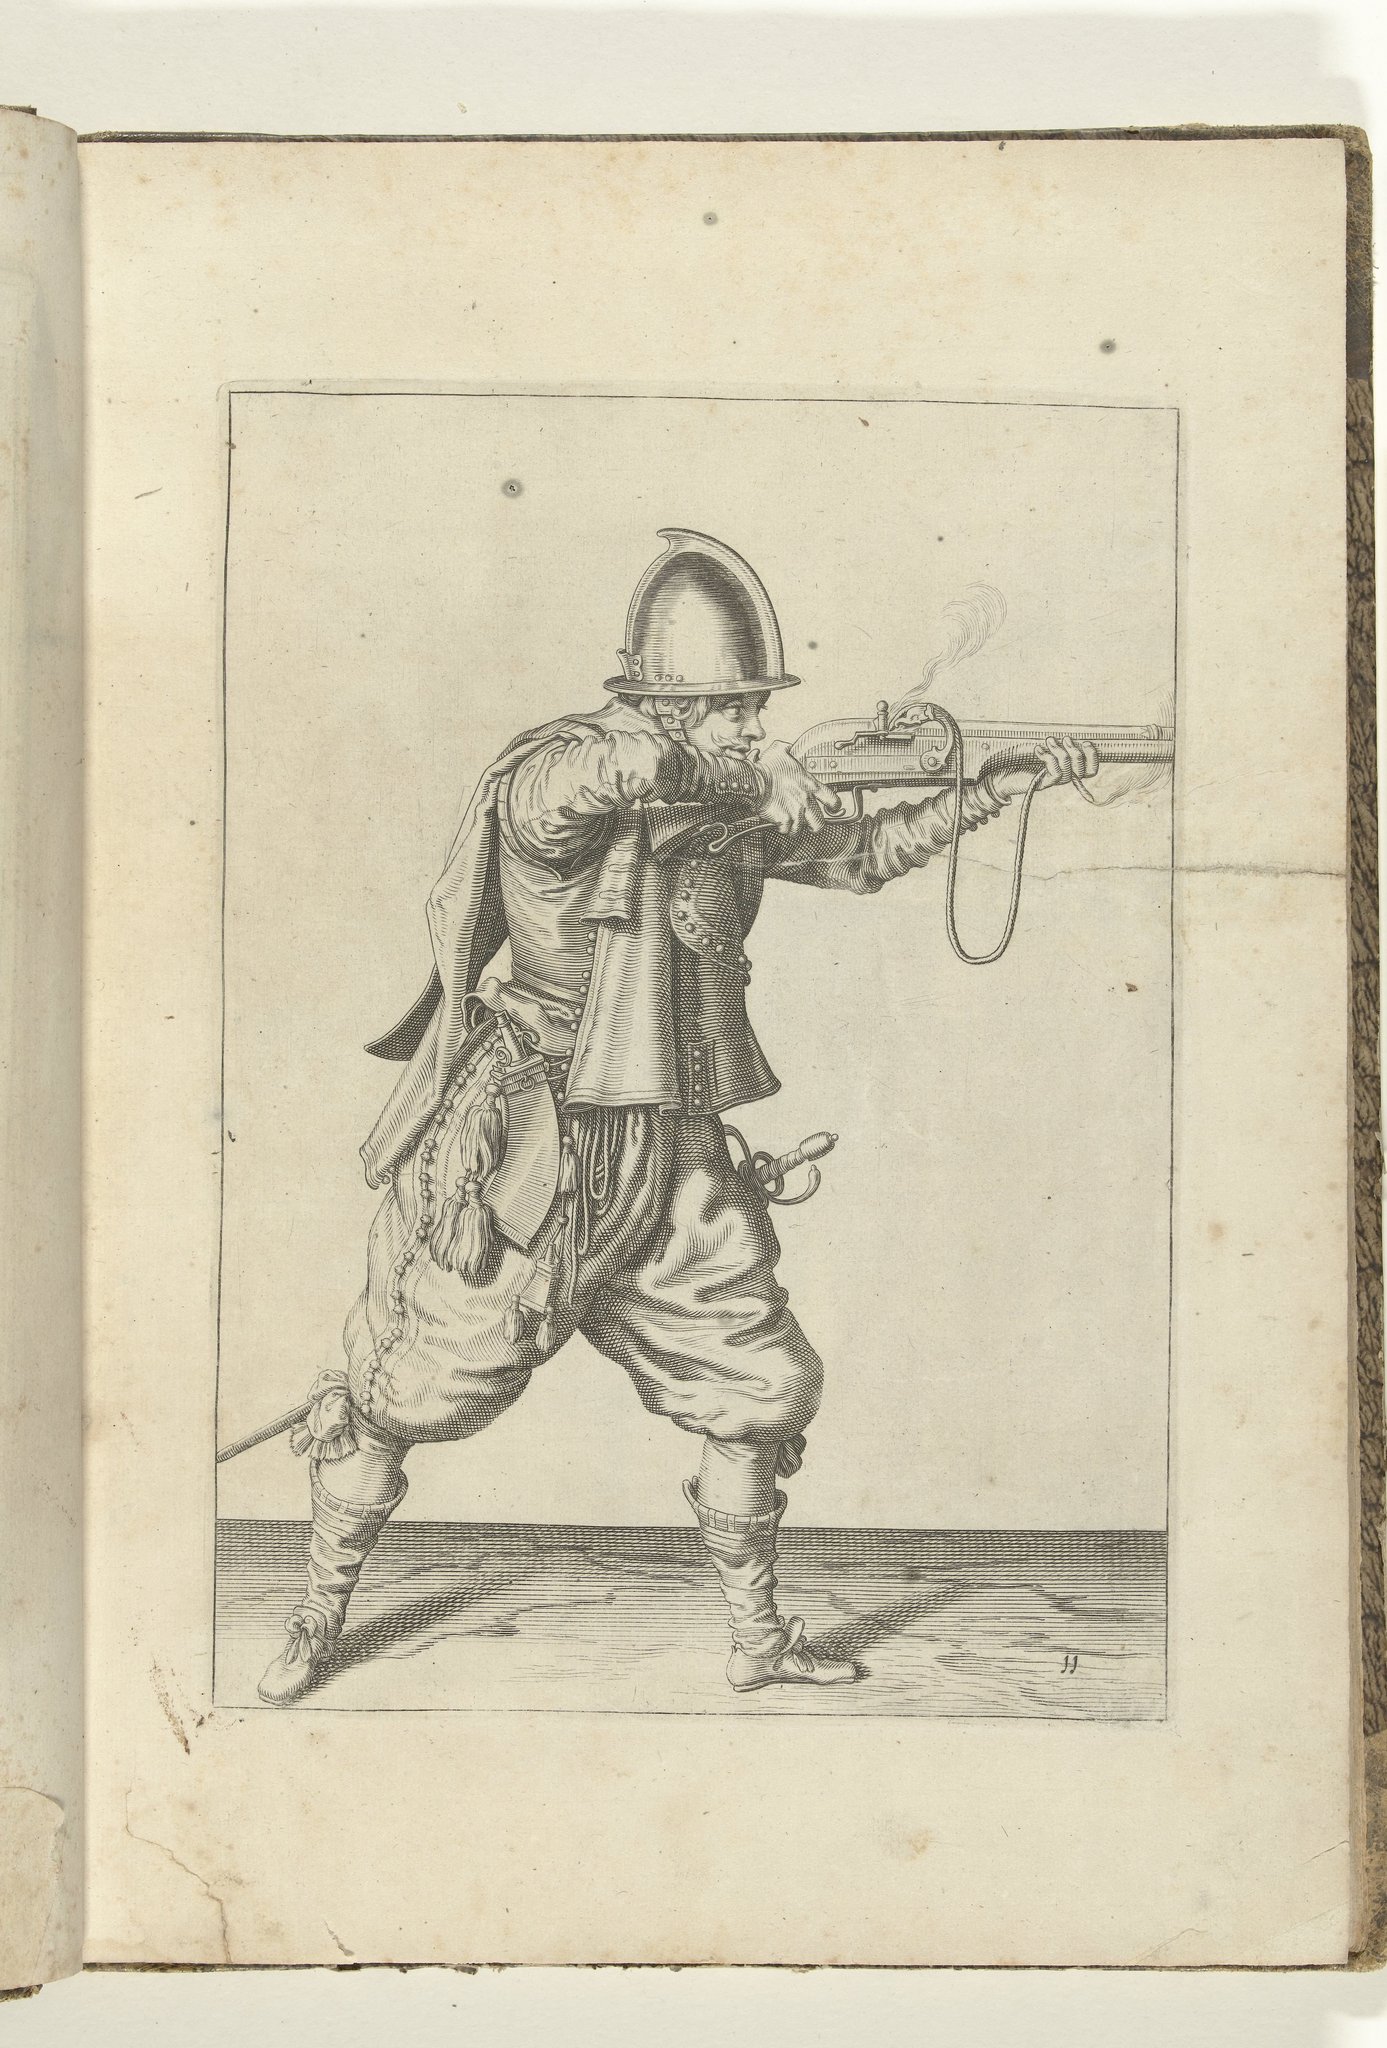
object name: print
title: Soldaat richt en vuurt de roer (nr. 11), ca. 1600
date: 1597-1608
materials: paper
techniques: engraving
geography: northern netherlands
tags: maurice (prince of orange), handling of weapons ~ military training, weapons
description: Een soldaat, ten voeten uit, naar rechts, die een roer (een bepaald type vuurwapen) met beide handen horizontaal houdt, richt en vuurt (nr. 11), ca. 1600. Plaat 11 in de instructies voor het hanteren van de roer: Brief enseignement, sur la representation des figures, du droit maniement de l'Harquebuse. Onderdeel van de illustraties in een Franse editie van J. de Gheyns Wapenhandelinghe: J. de Gheyn, Maniement d'armes, d'arquebuses, mousquetz et piques : en conformité de l'ordre de Mour le Prince Maurice, Prince d'Orange, Amsterdam 1608. Krijgswezen rond 1600.